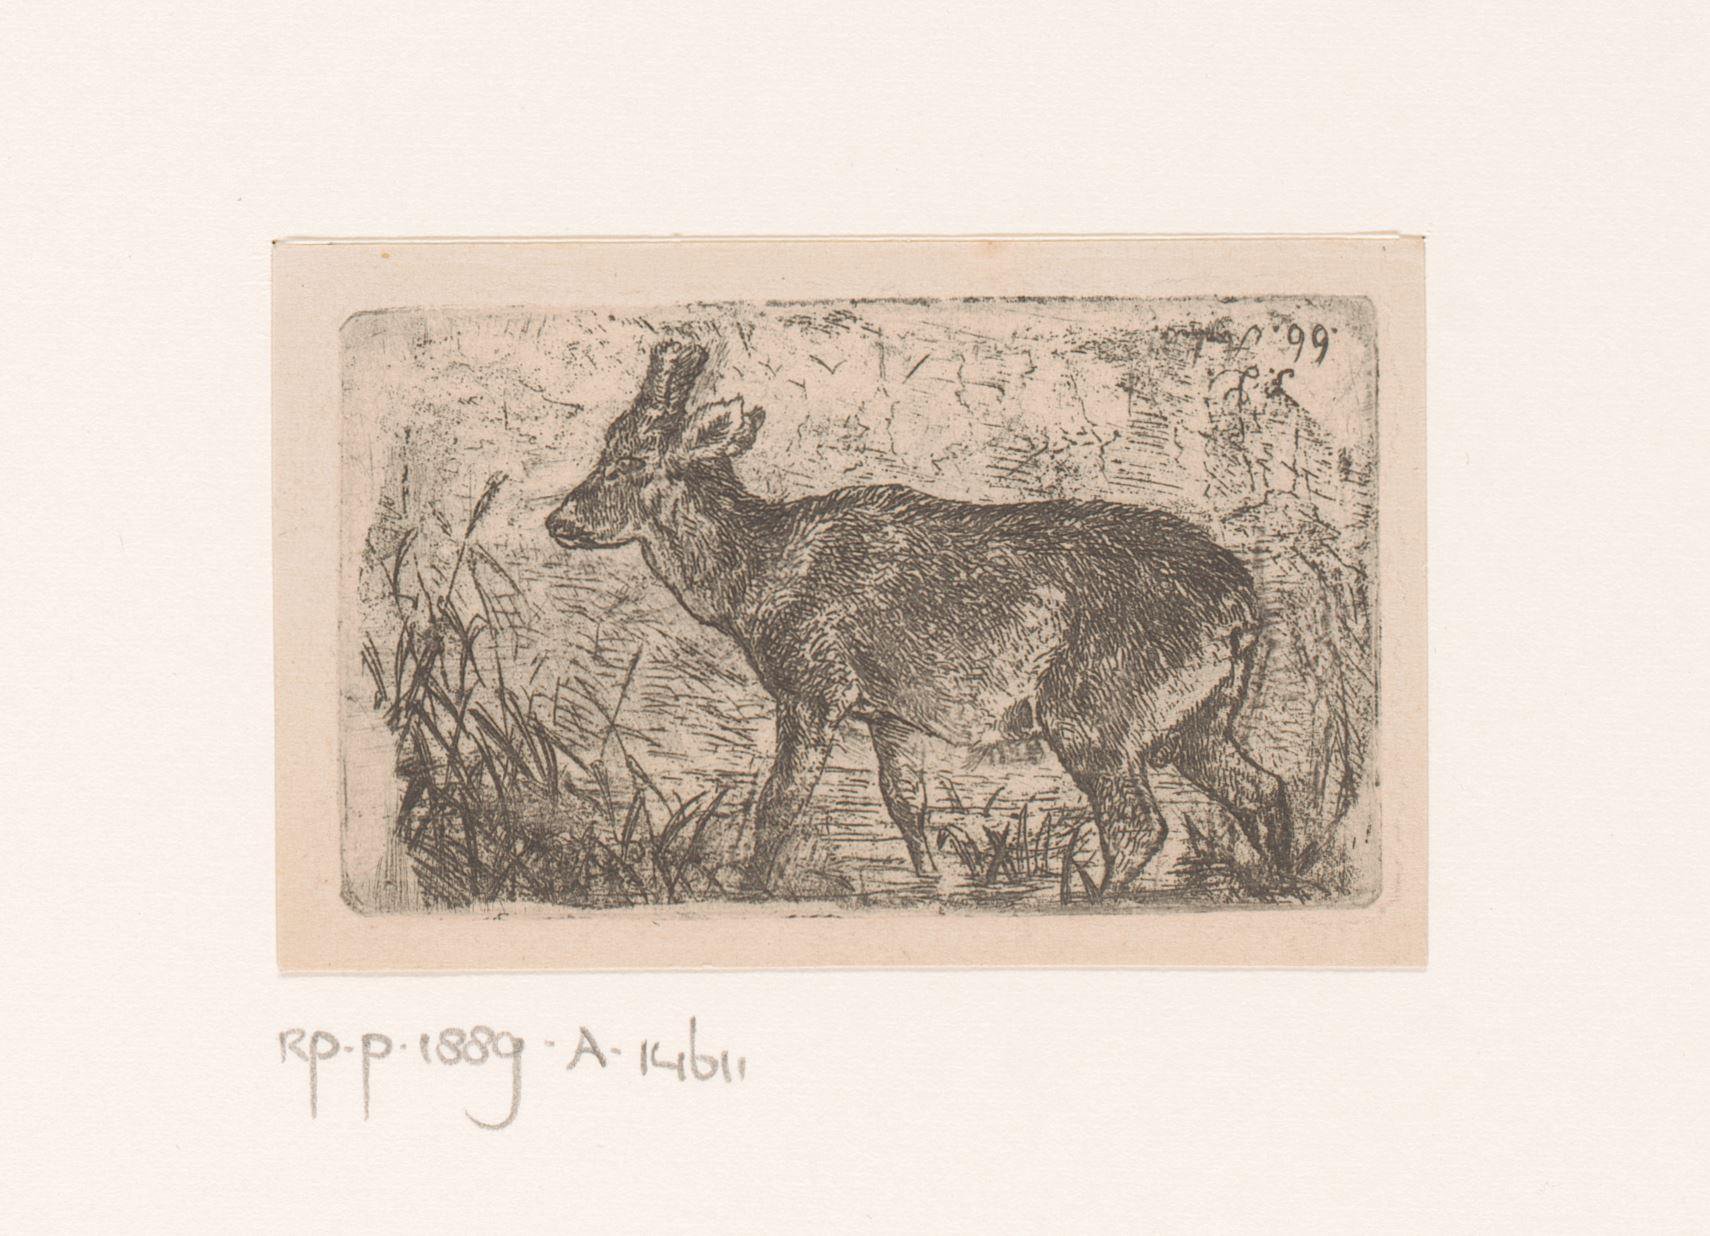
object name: print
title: Ree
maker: f. lautenberger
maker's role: print maker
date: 1866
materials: paper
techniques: etching, intaglio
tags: hoofed animals: deer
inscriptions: collector's mark: Lugt 2228, annotation: ‘Lautenberger van Francfort heeft ongeveer 5 jaar te Antwerpen gewoond, hij was leerling van den ouden van Kuyk. Zijn broeder was officier bij het Oostenrijksche leger’